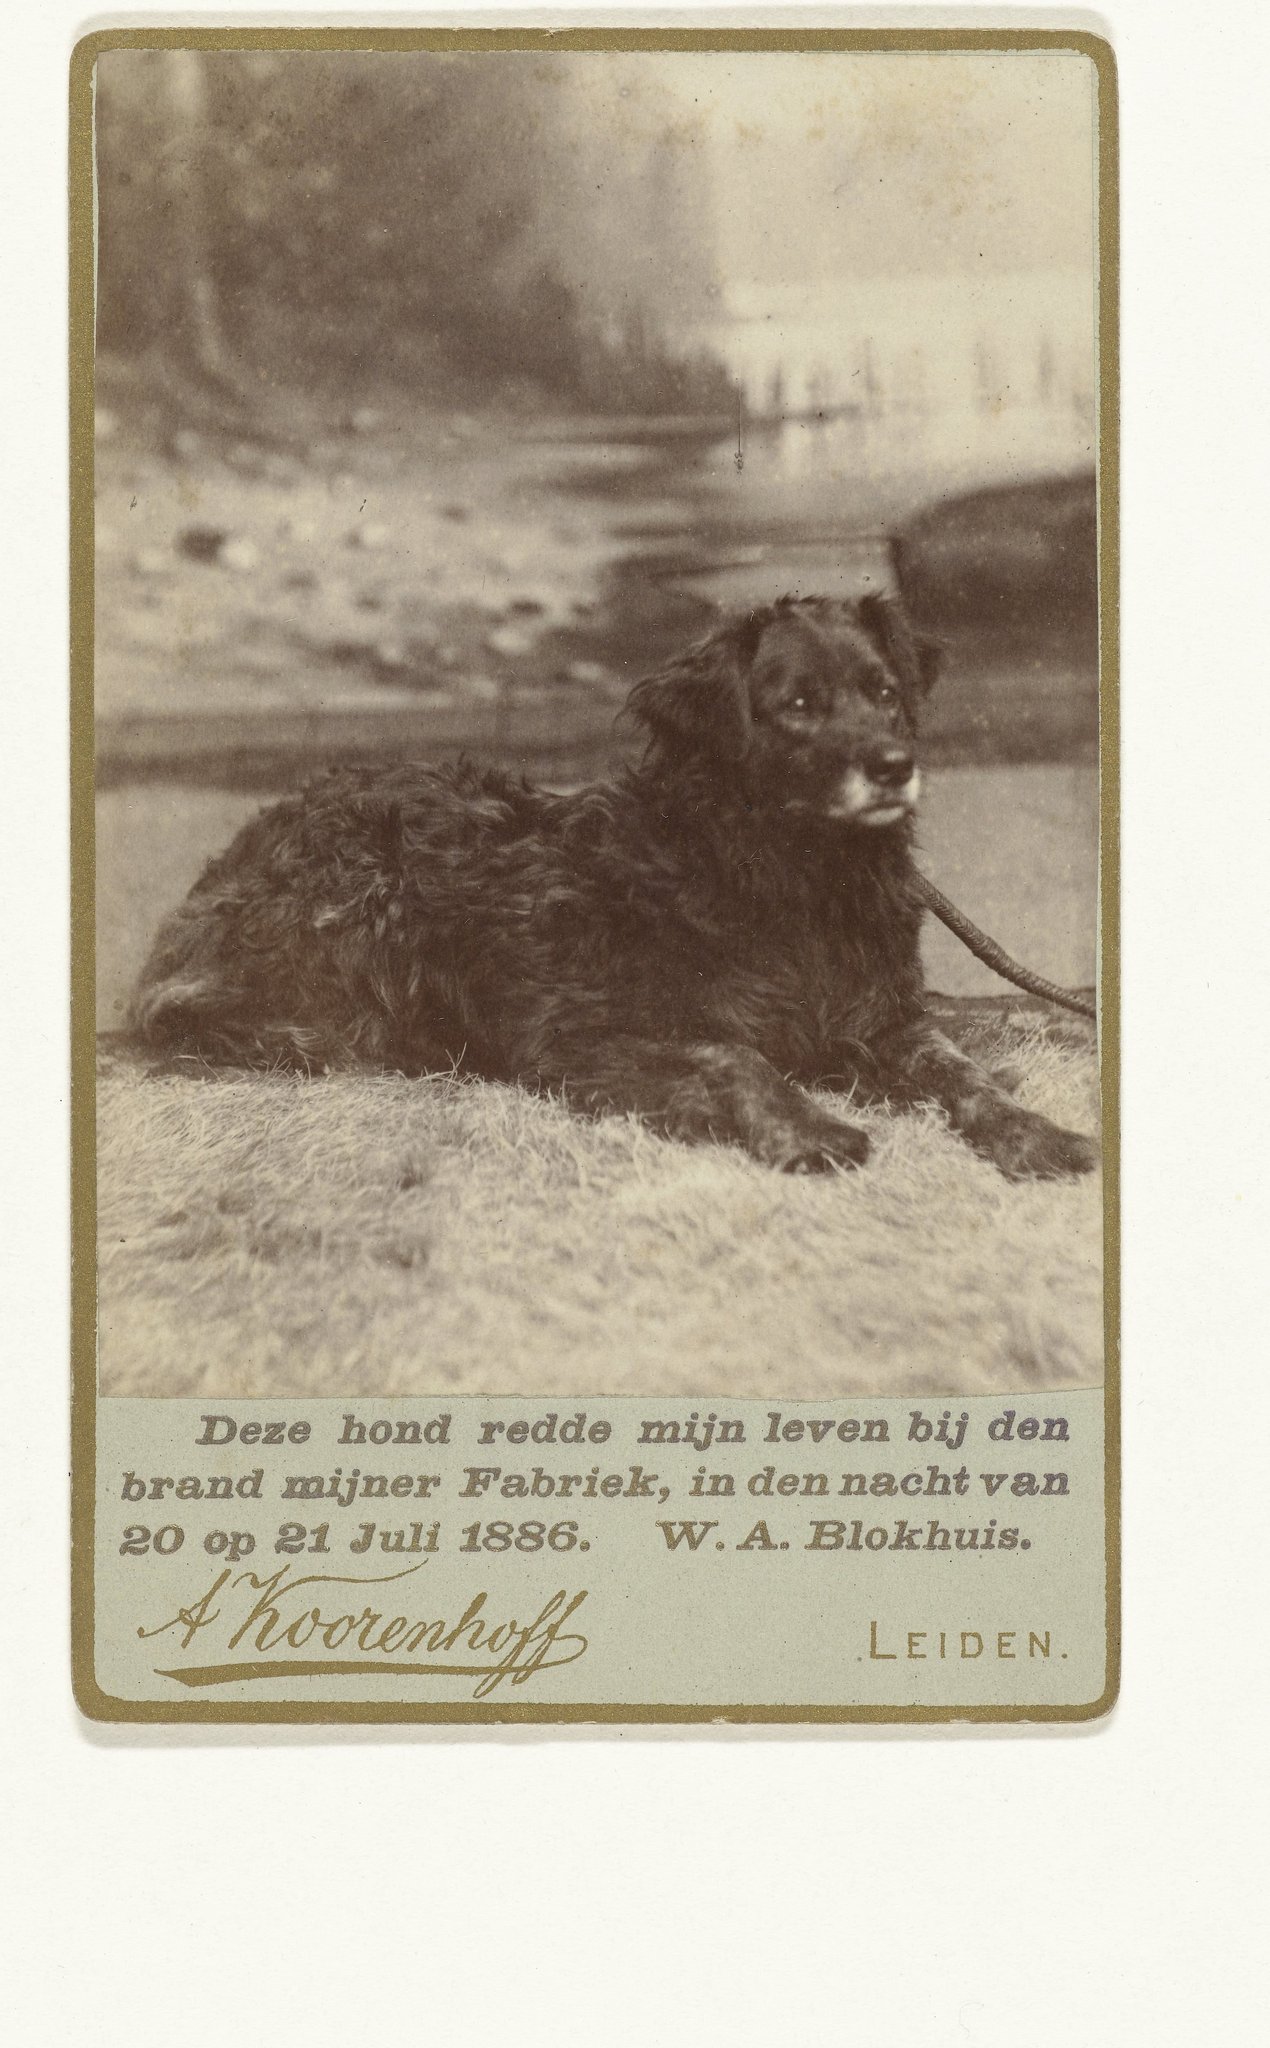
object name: carte de visite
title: Deze hond redde mijn leven bij de brand mijner fabriek, in den nacht van 20 op 21 juli 1886. W.A. Blokhuis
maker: abraham koorenhoff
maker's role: fotograaf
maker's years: 1844-1917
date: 1888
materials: cardboard, paper, photographic support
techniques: albumen print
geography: leiden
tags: dog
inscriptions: inscription: ‘A. Koorenhoff / Photographe / VAN Z.M. DEN KONING DER NEDERLANDEN / TE / LEIDEN / Gerecht No 5 / by de Pieterskerk. / [...] / Specialiteit in Vergroote Portretten enz. / 1888. [...]’, inscription: ‘Deze hond redde mijn leven bij den / brand mijner Fabriek, in den nacht van / 20 op 21 Juli 1886. W.A. Blokhuis’, signature: ‘A Koorenhoff LEIDEN.’